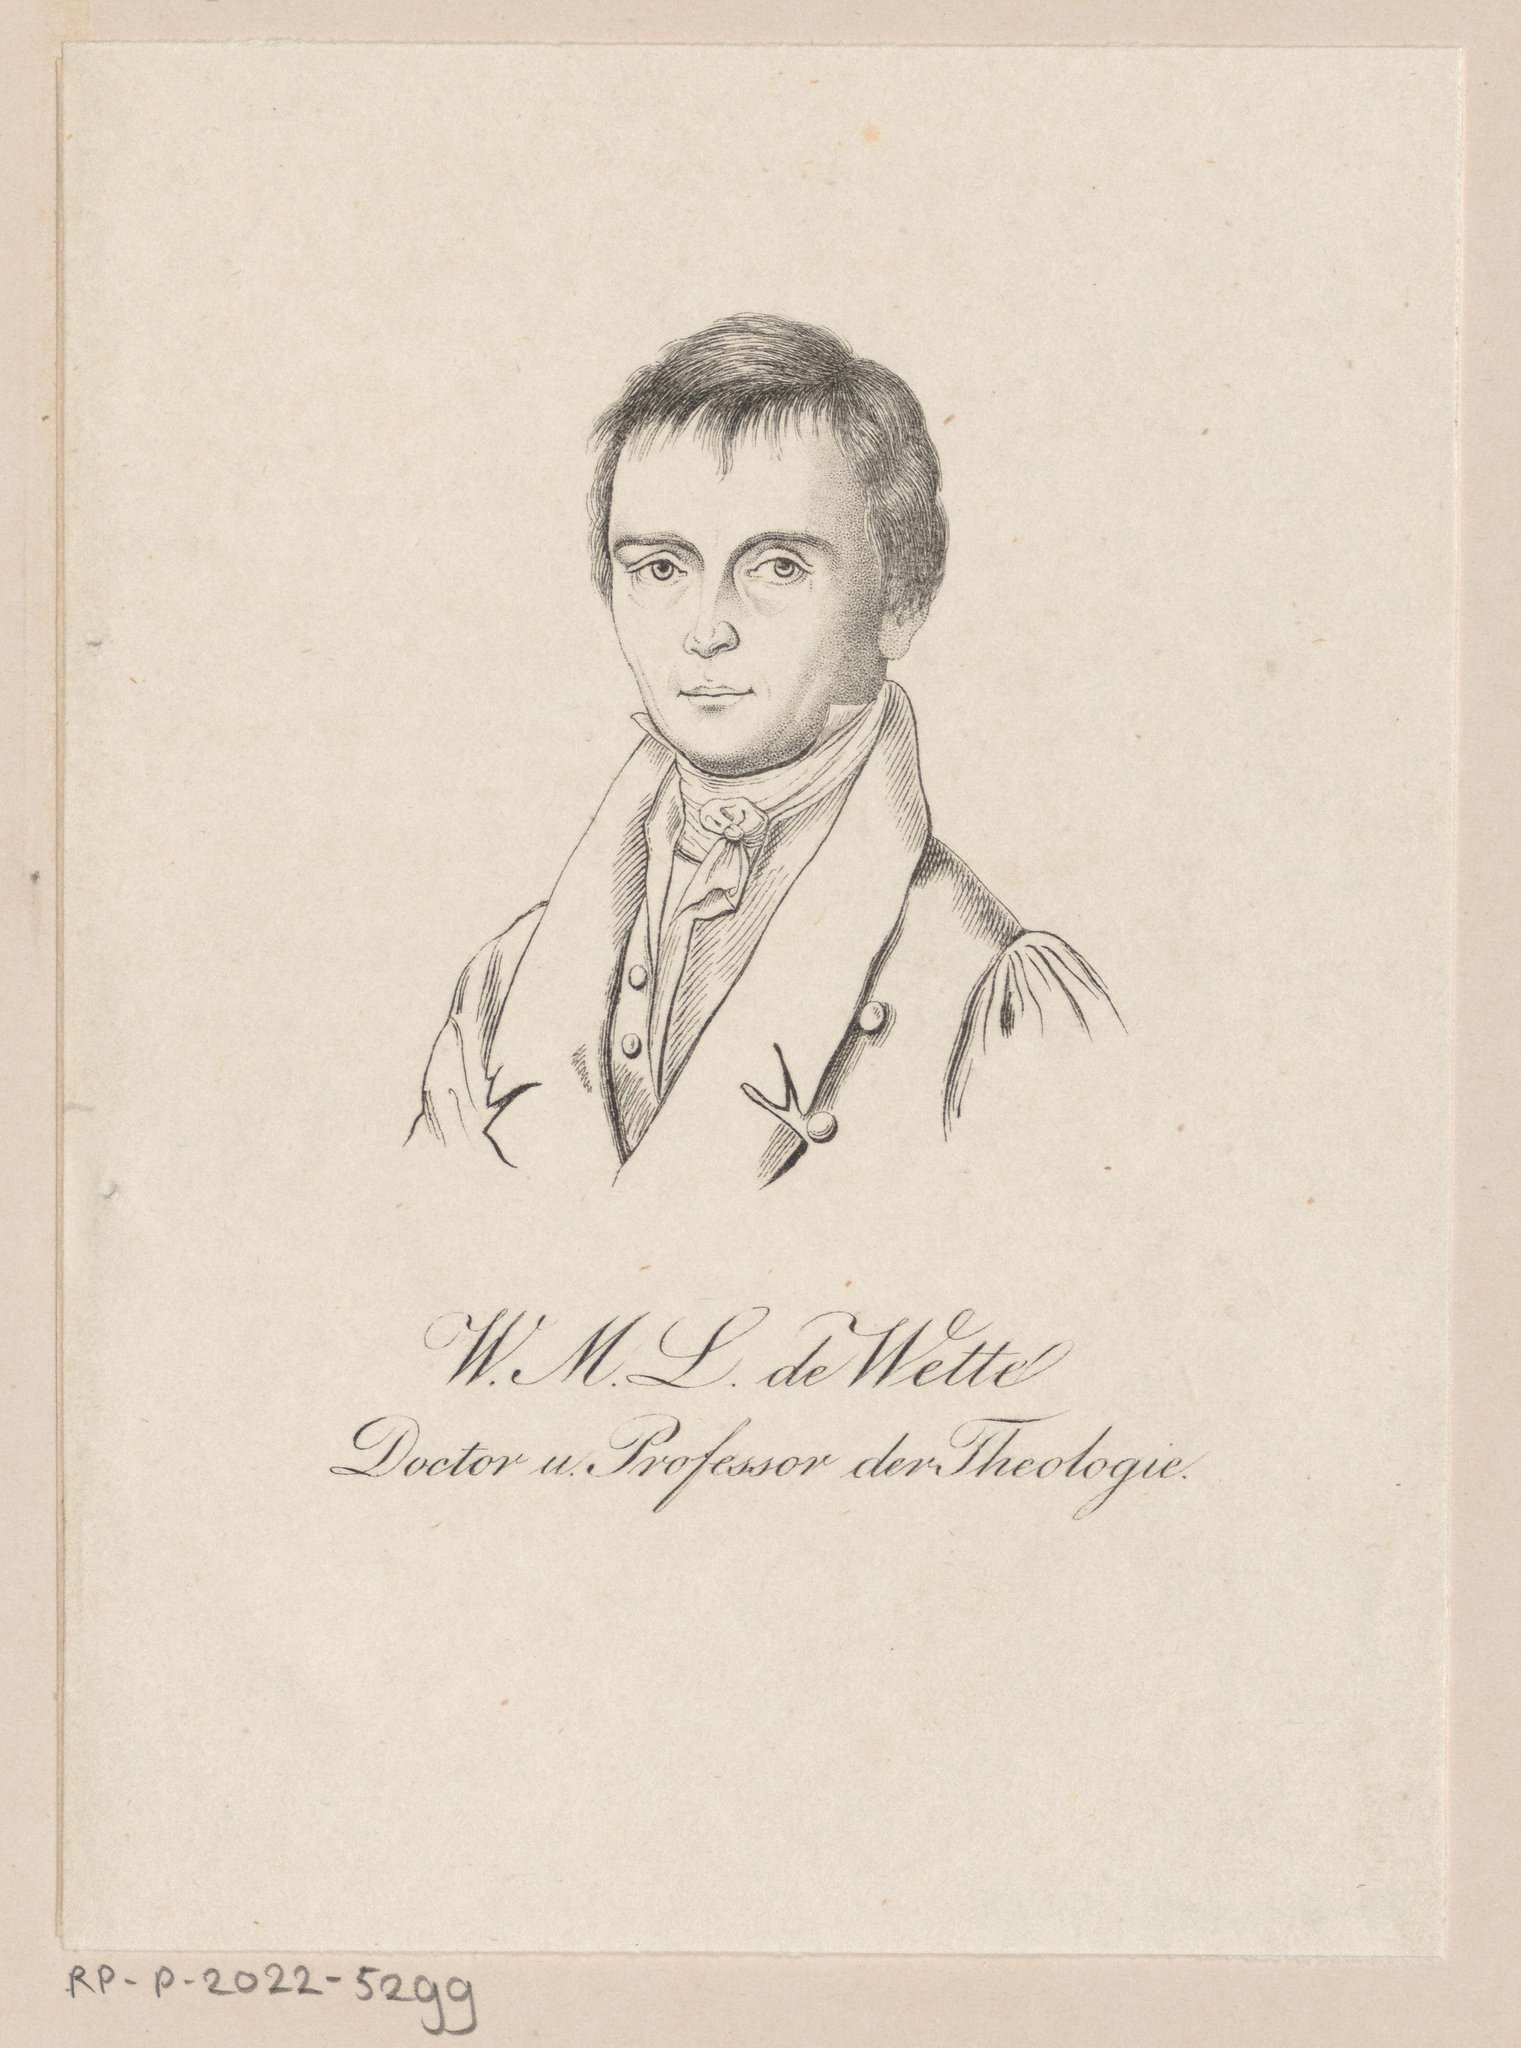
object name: print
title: Portret van Wilhelm Martin Leberecht de Wette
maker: Anonymous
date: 1807-1870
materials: paper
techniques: engraving, etching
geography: germany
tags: theologian, historical persons